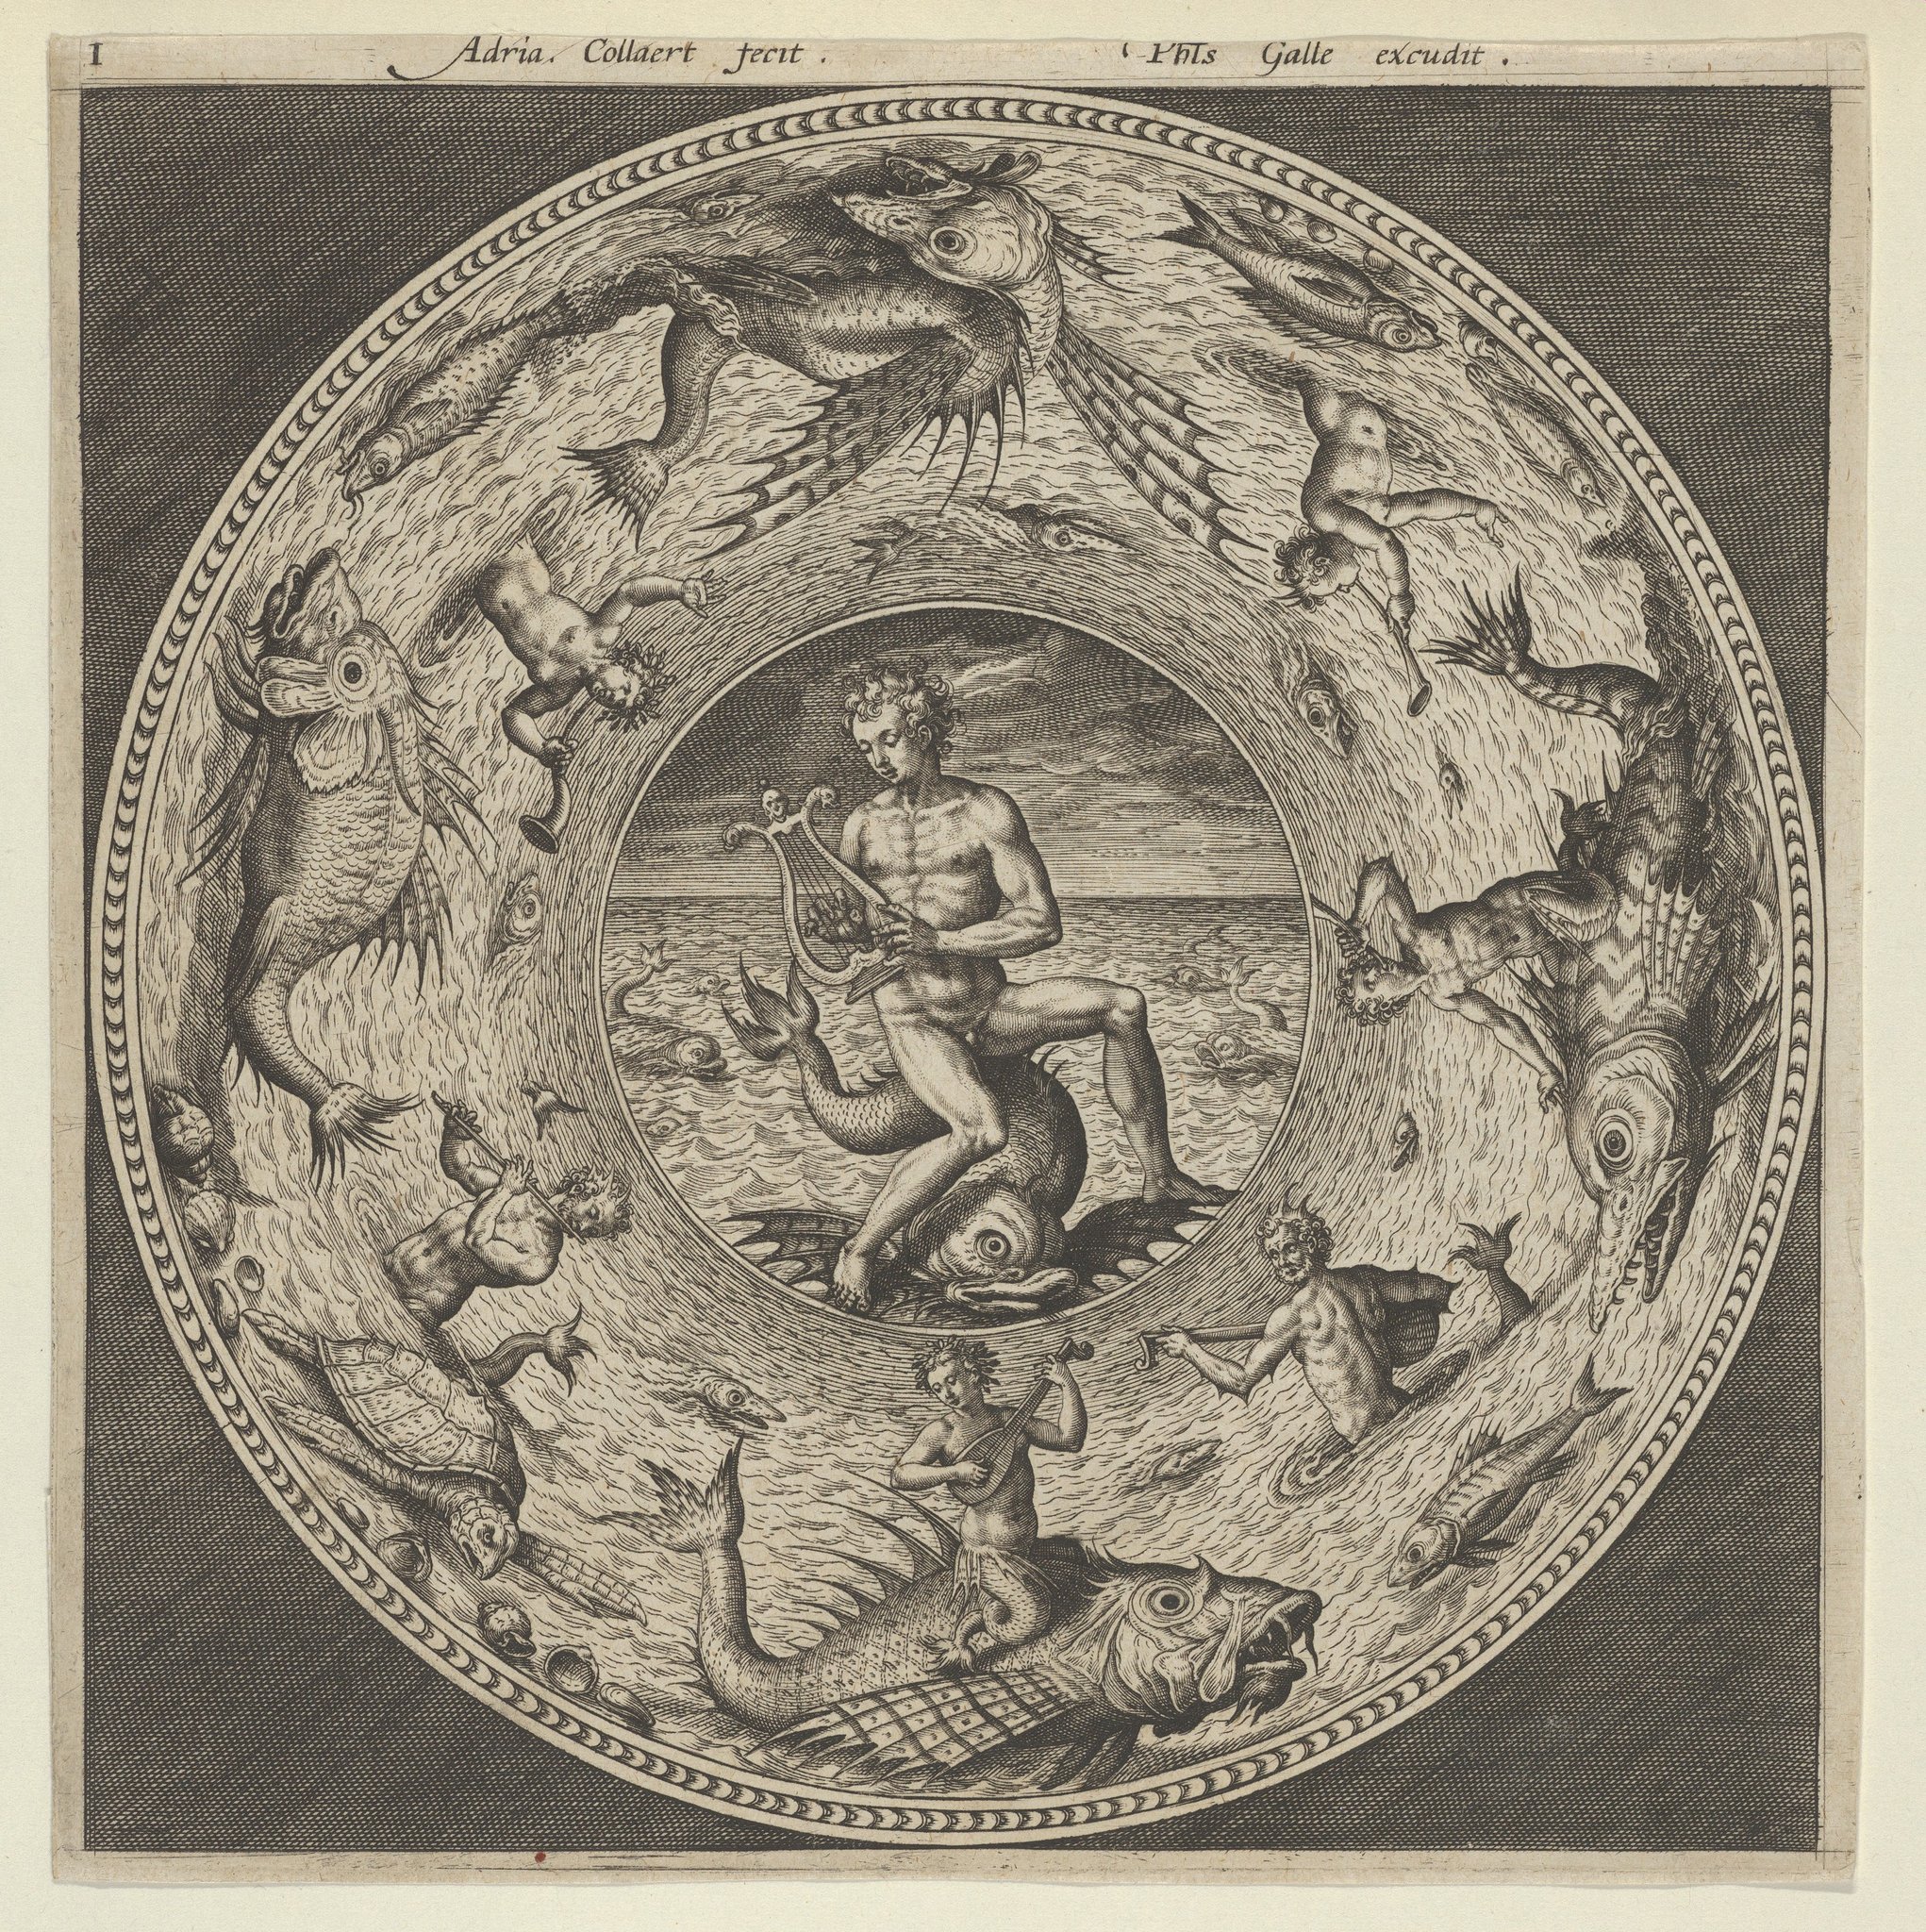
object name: print ornament architecture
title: Design for a Plate with Arion Riding a Dolphin in a Medallion Bordered by Sea Monsters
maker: adriaen collaert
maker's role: artist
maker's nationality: netherlandish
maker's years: 1560-1618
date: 1600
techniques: engraving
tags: musical instruments,male nudes,monsters,dolphins,turtles